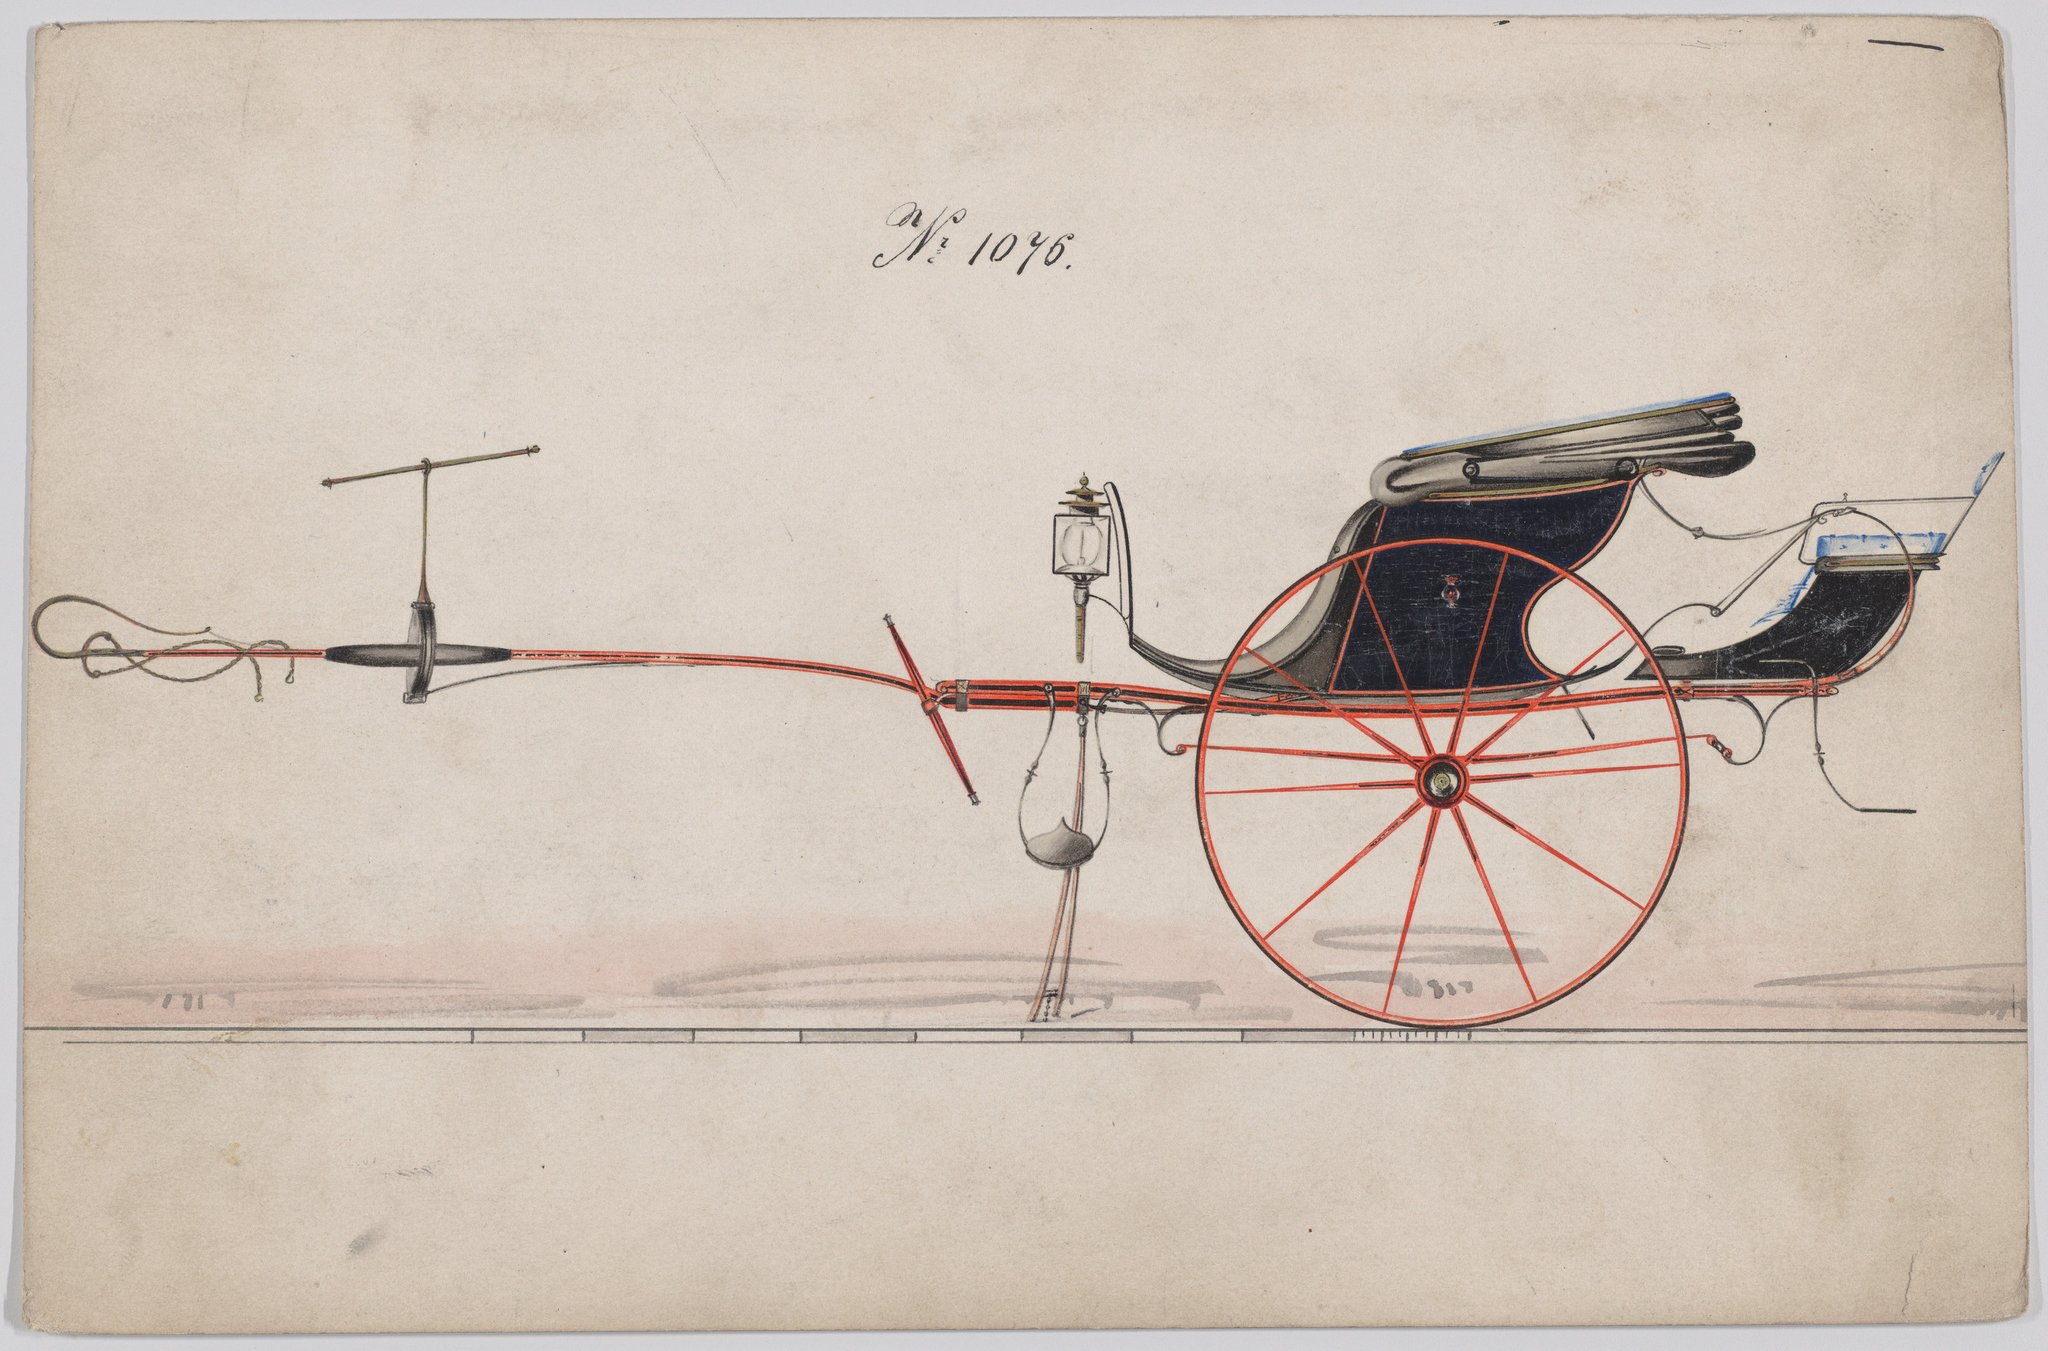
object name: drawing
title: Curricle # 1076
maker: brewster & co.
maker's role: manufacturer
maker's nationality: american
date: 1870-1874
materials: gouache, gum arabic, ink, watercolor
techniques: pen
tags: carriages